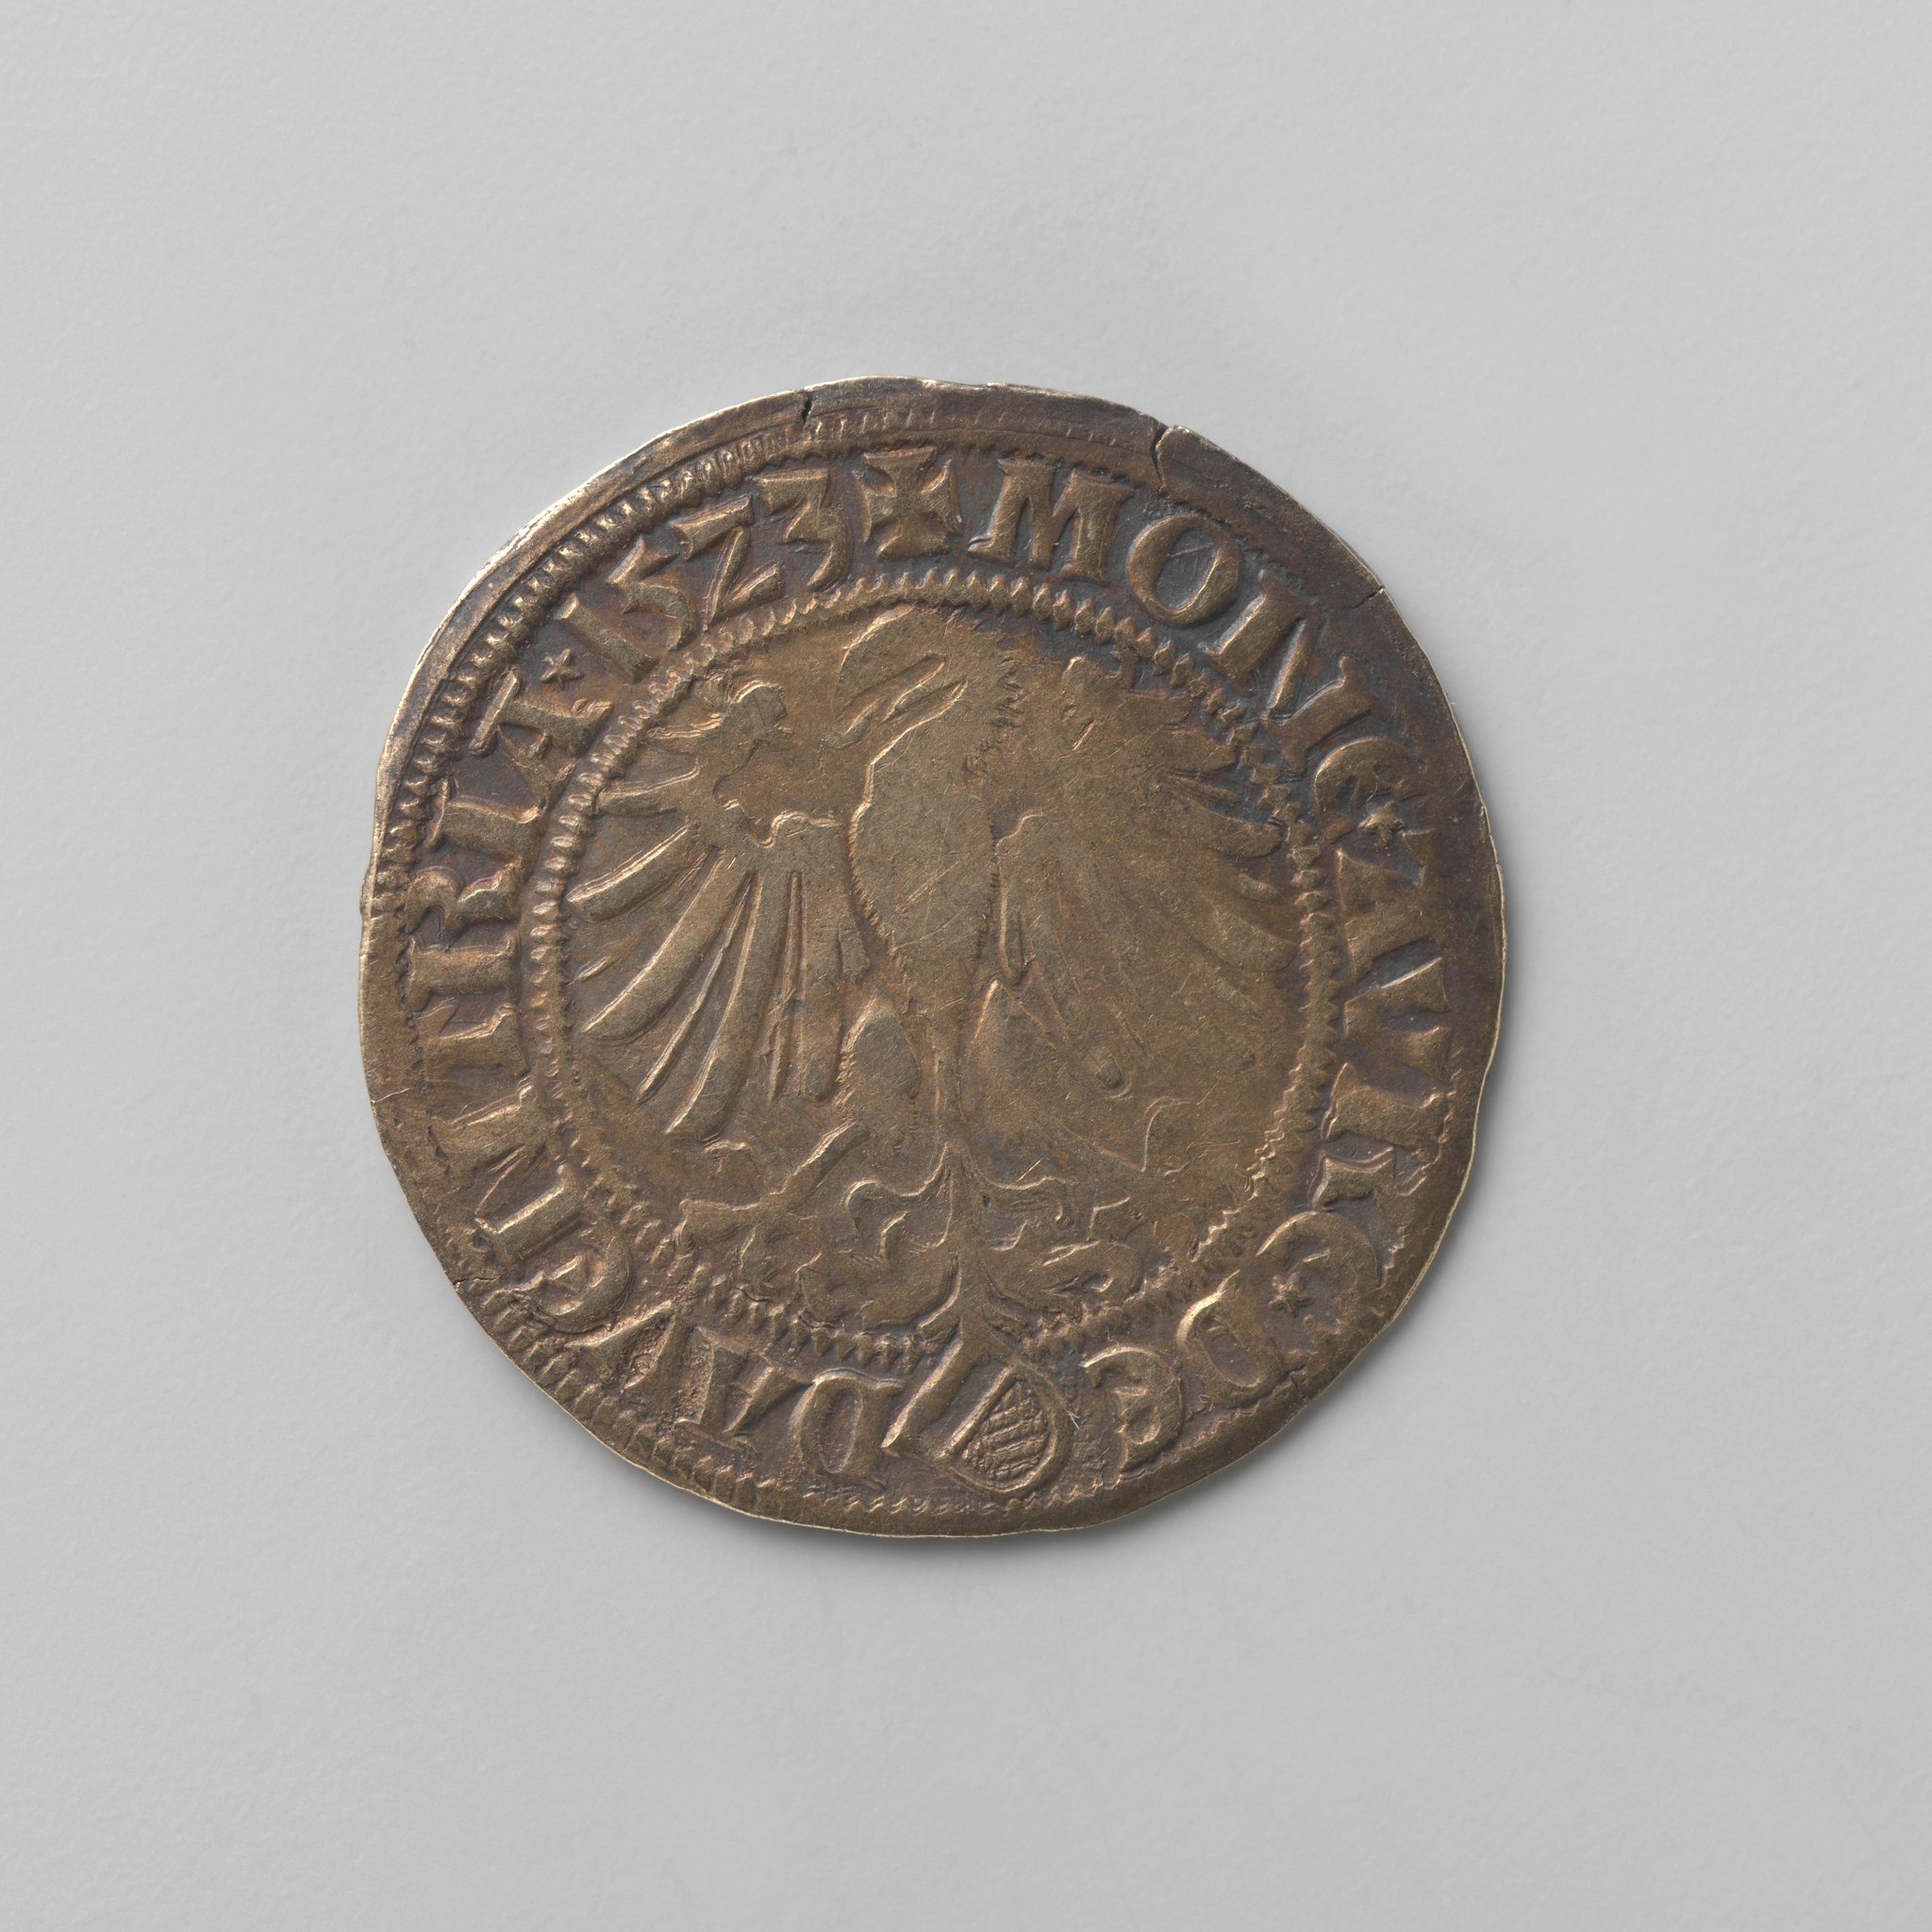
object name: adelaarsgulden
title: Deventer, adelaarsgulden, 1523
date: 1523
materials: gold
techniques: striking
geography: deventer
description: Gouden munt. Voorzijde: eenkoppige adelaar met onder zijn poten schuingeplaatst wapenschild van Oversticht. Jaartal in omschrift. Keerzijde: binnen dubbellijnige versierde driepas rijksappel.